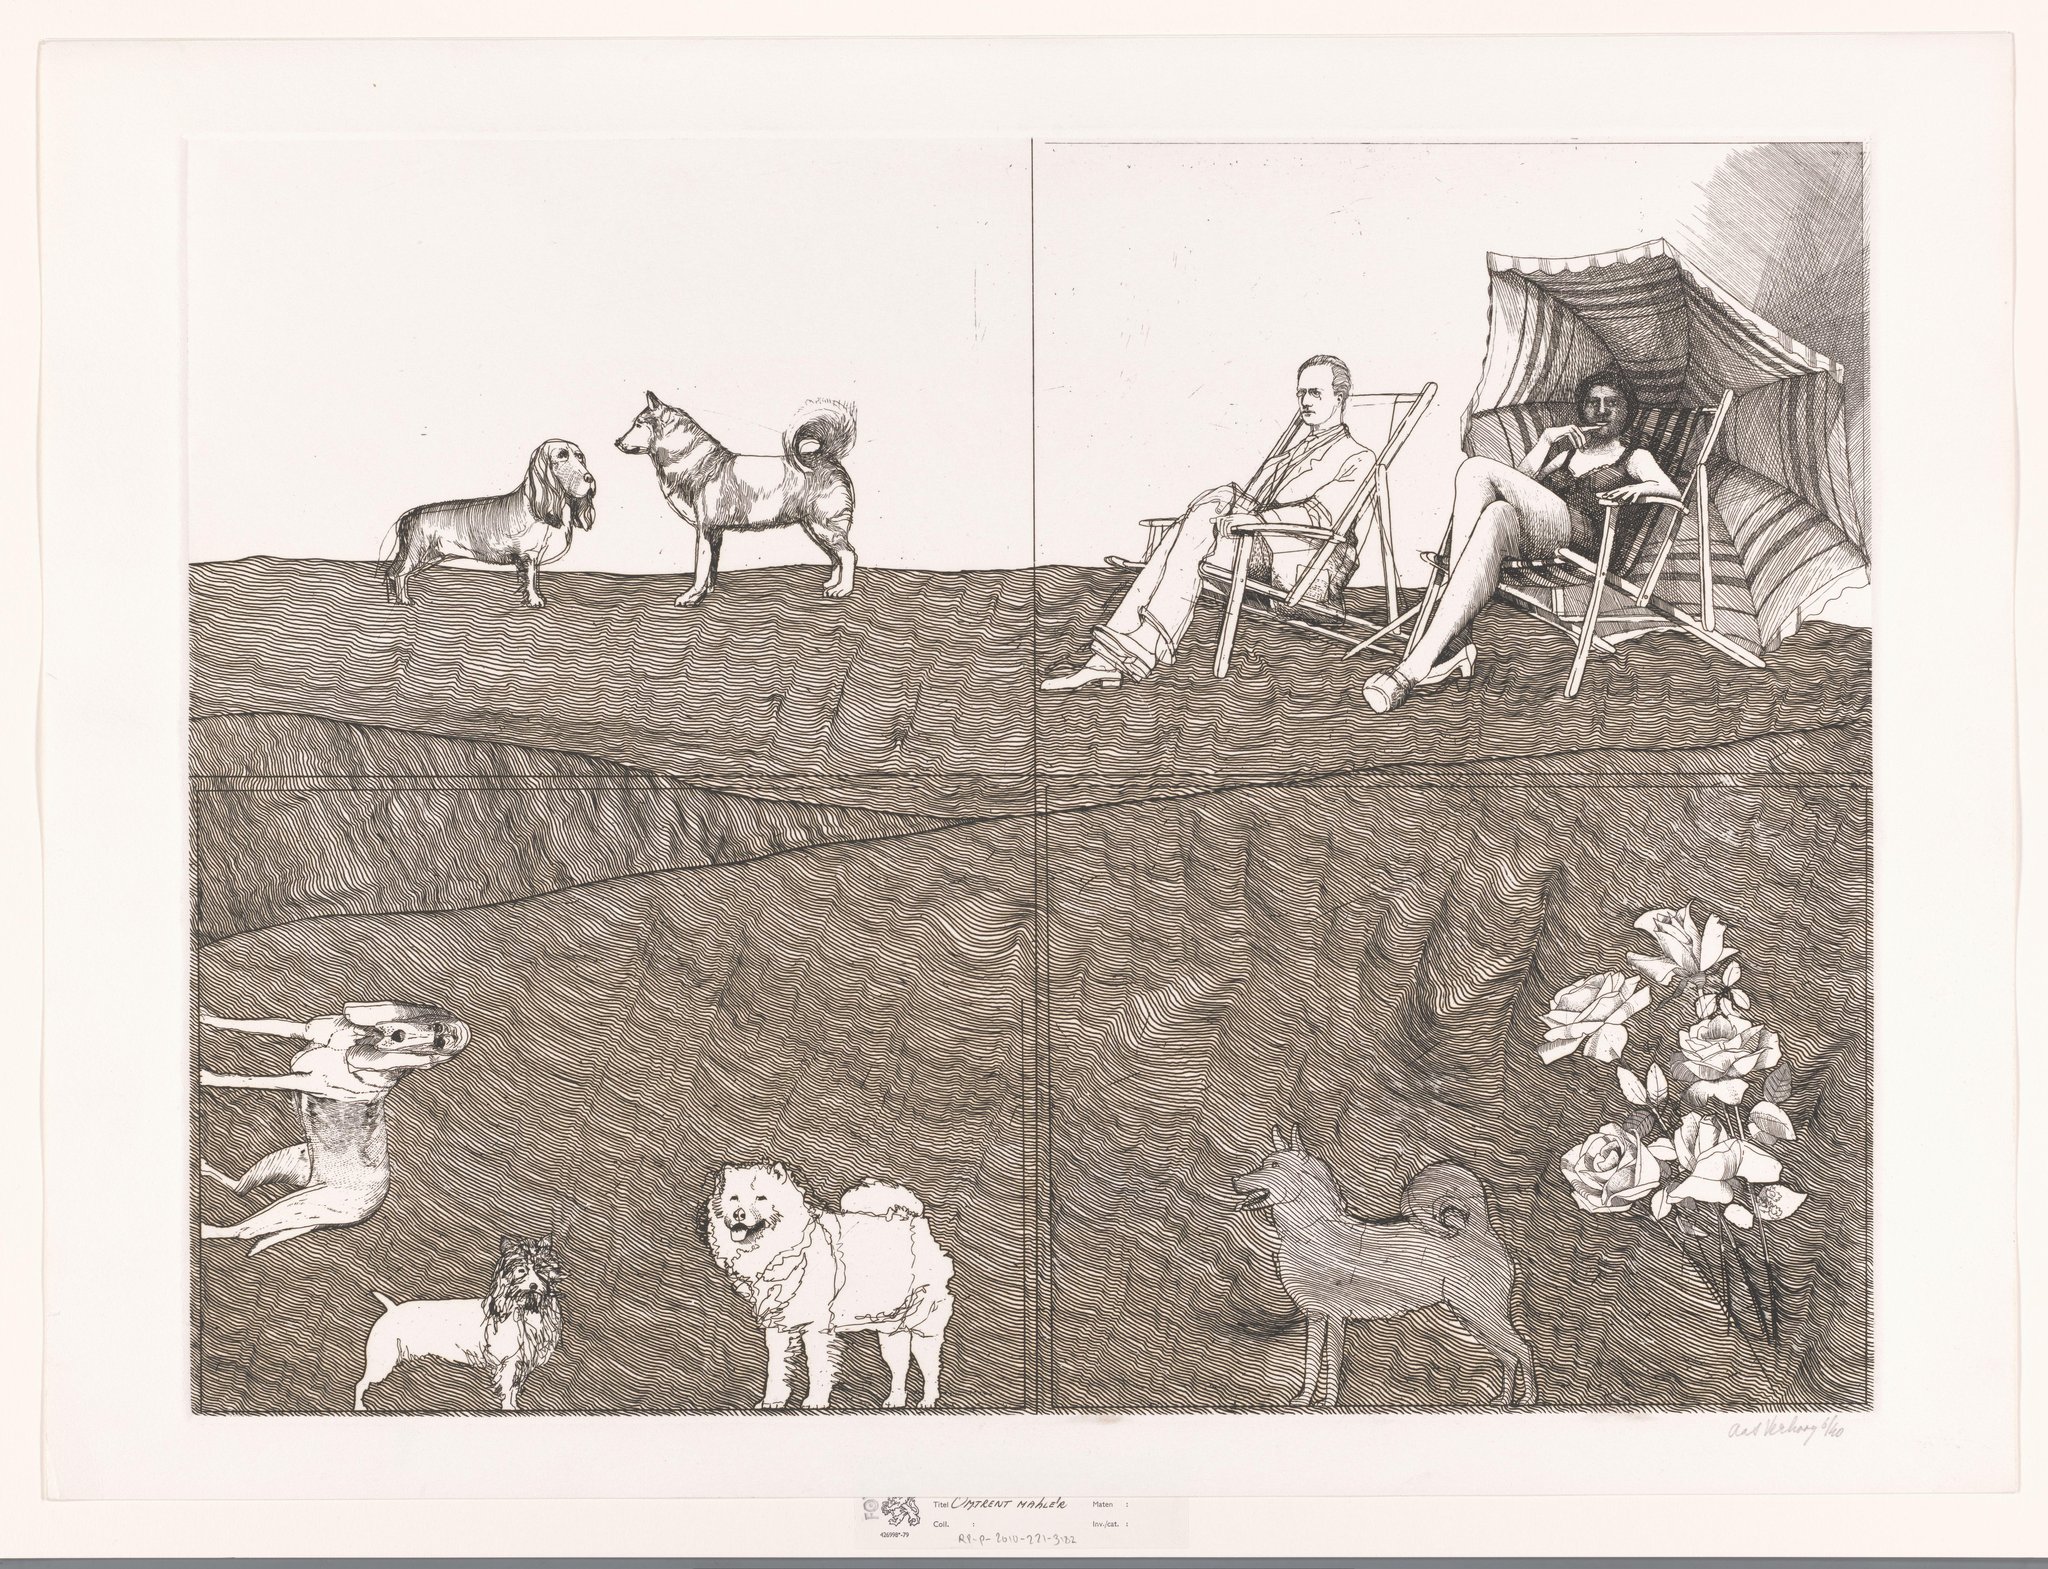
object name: print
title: Omtrent Mahler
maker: aat verhoog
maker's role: print maker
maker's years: 1933-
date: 1972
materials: paper, ink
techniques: etching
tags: vienna, gustav mahler, dog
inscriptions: signature: ‘Aat Verhoog’, edition: ‘6/40’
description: Landschap met een hoge horizon en zes verschillende honden verspreid over het vlak, rechtsboven een man en een vrouw zittend in strandstoelen bij een parasol.